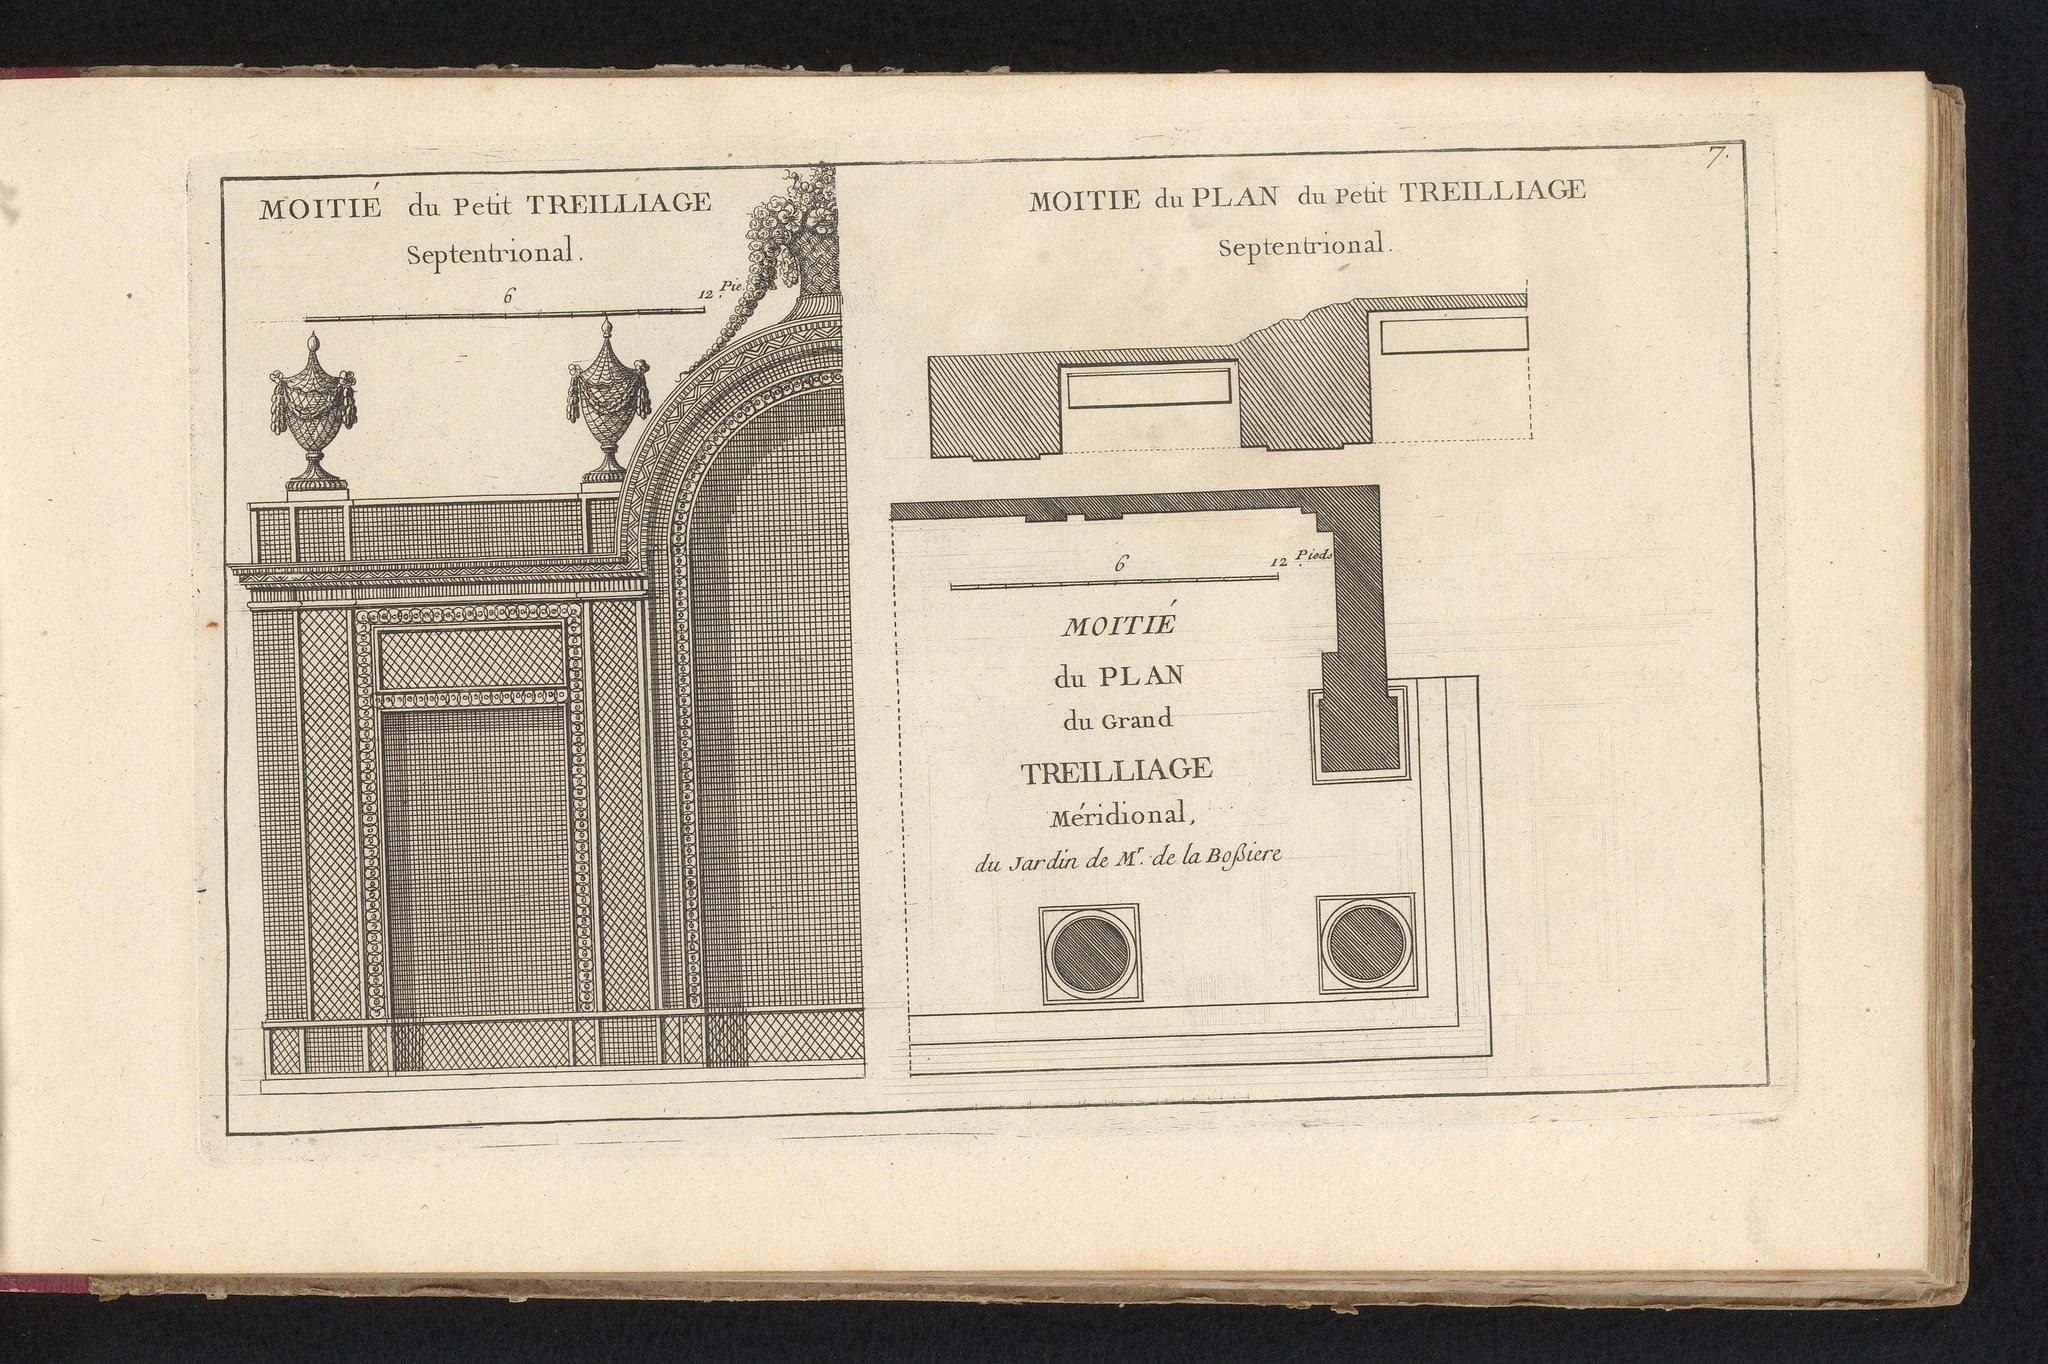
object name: album leaf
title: Ontwerp voor latwerk in de tuin bij Pavillon la Bouëxière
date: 1775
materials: paper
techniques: engraving, etching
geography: paris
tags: trellis, plan, map of garden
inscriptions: collector's mark: Lugt 2760, collector's mark: Lugt 2228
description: De serie 'Jardins anglo-chinois à la mode' verscheen in totaal in 21 zogeheten 'cahiers' (afleveringen). De huidige prent komt uit het eerste 'cahier'. Het Rijksmuseum Amsterdam bezit drie banden met daarin in totaal zes 'cahiers' van deze reeks. In de documentatie wordt verwezen naar een in de bibliotheek van het Rijksmuseum Amsterdam aanwezige facsimile van het complete werk.